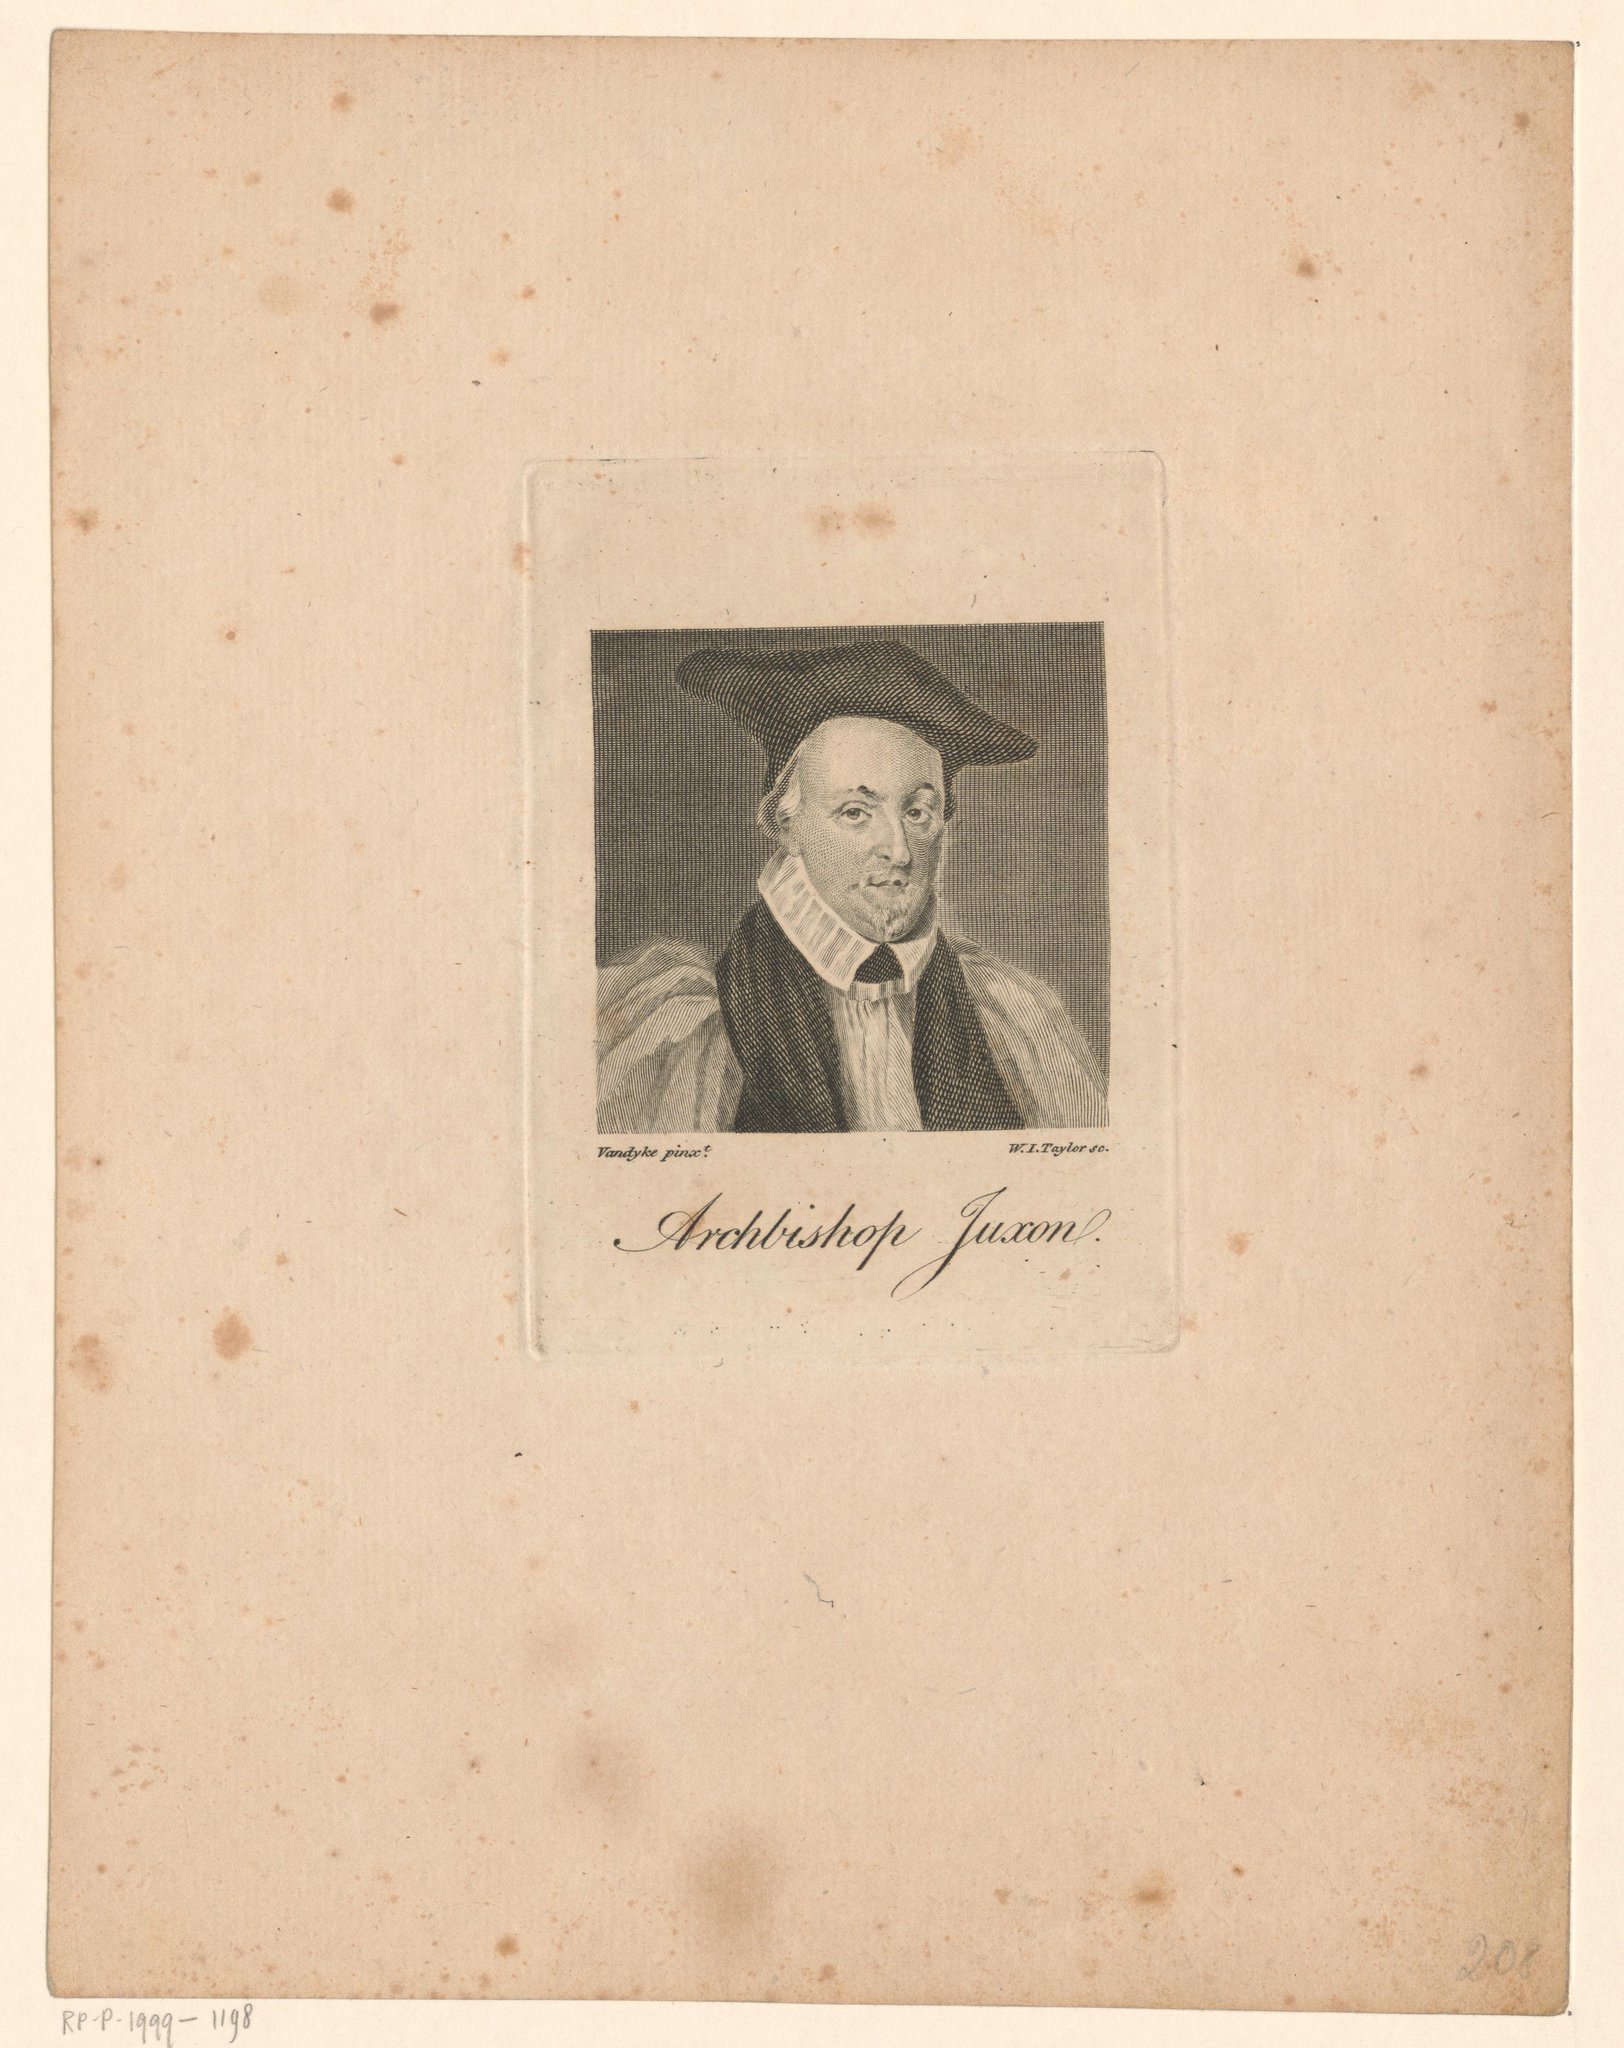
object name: print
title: Portret van William van Juxon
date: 1794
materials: paper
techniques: engraving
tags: archbishop, bishop, etc. (roman catholic), historical persons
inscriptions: collector's mark: Lugt 2228, inscription: ‘Portr. 61469’, collector's mark: Lugt 2760